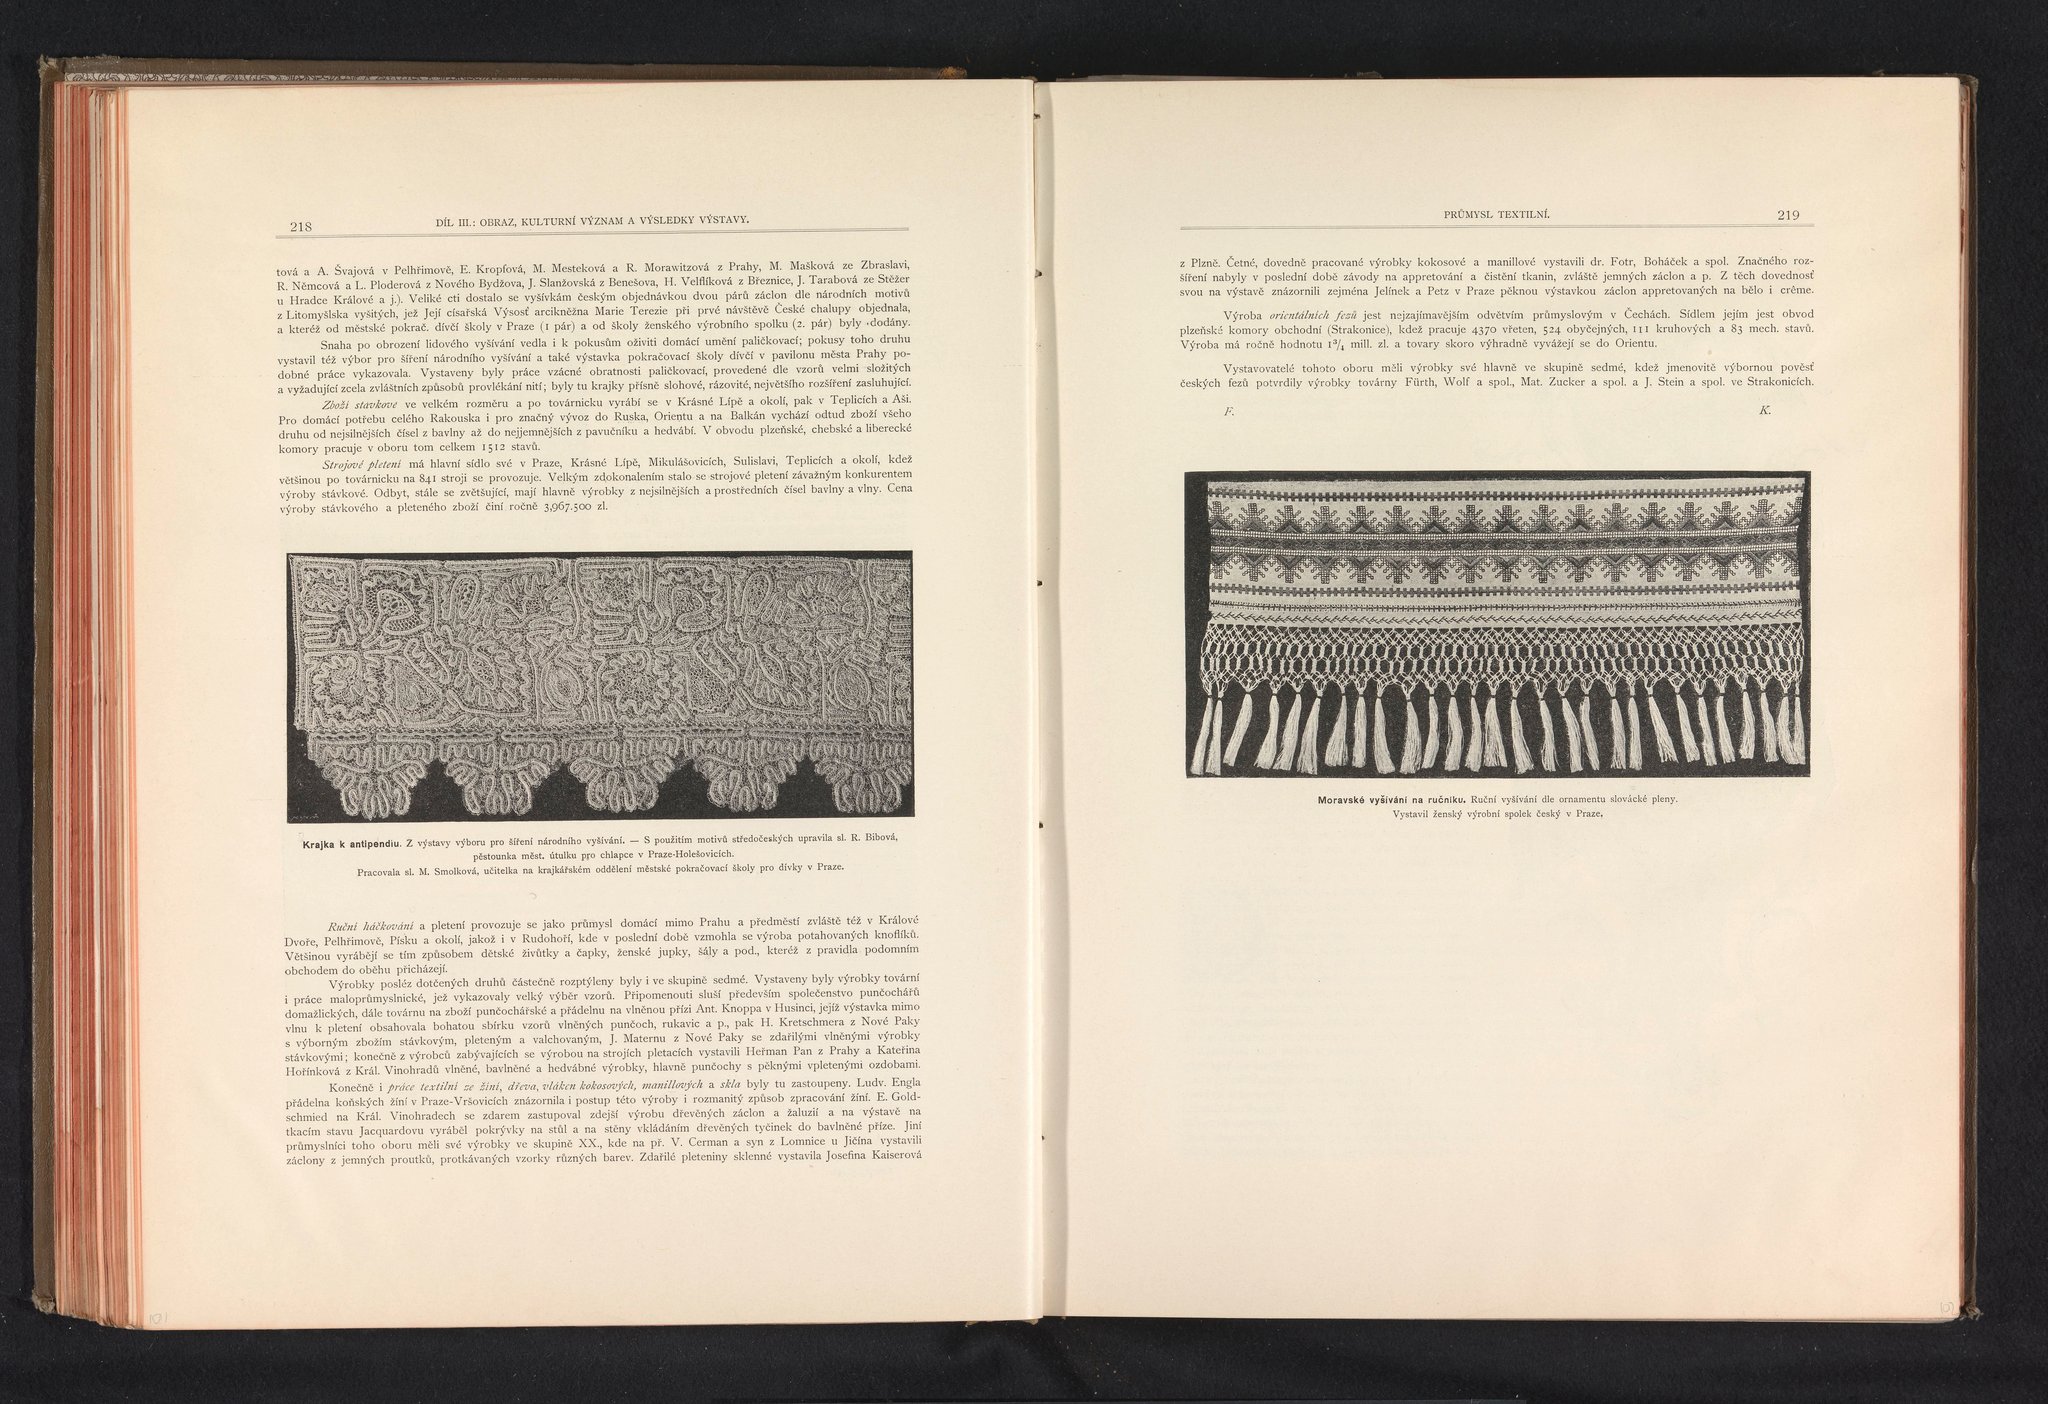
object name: photomechanical print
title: Geborduurde handdoek uit Moravië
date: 1890-1895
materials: paper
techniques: autotype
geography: prague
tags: towel